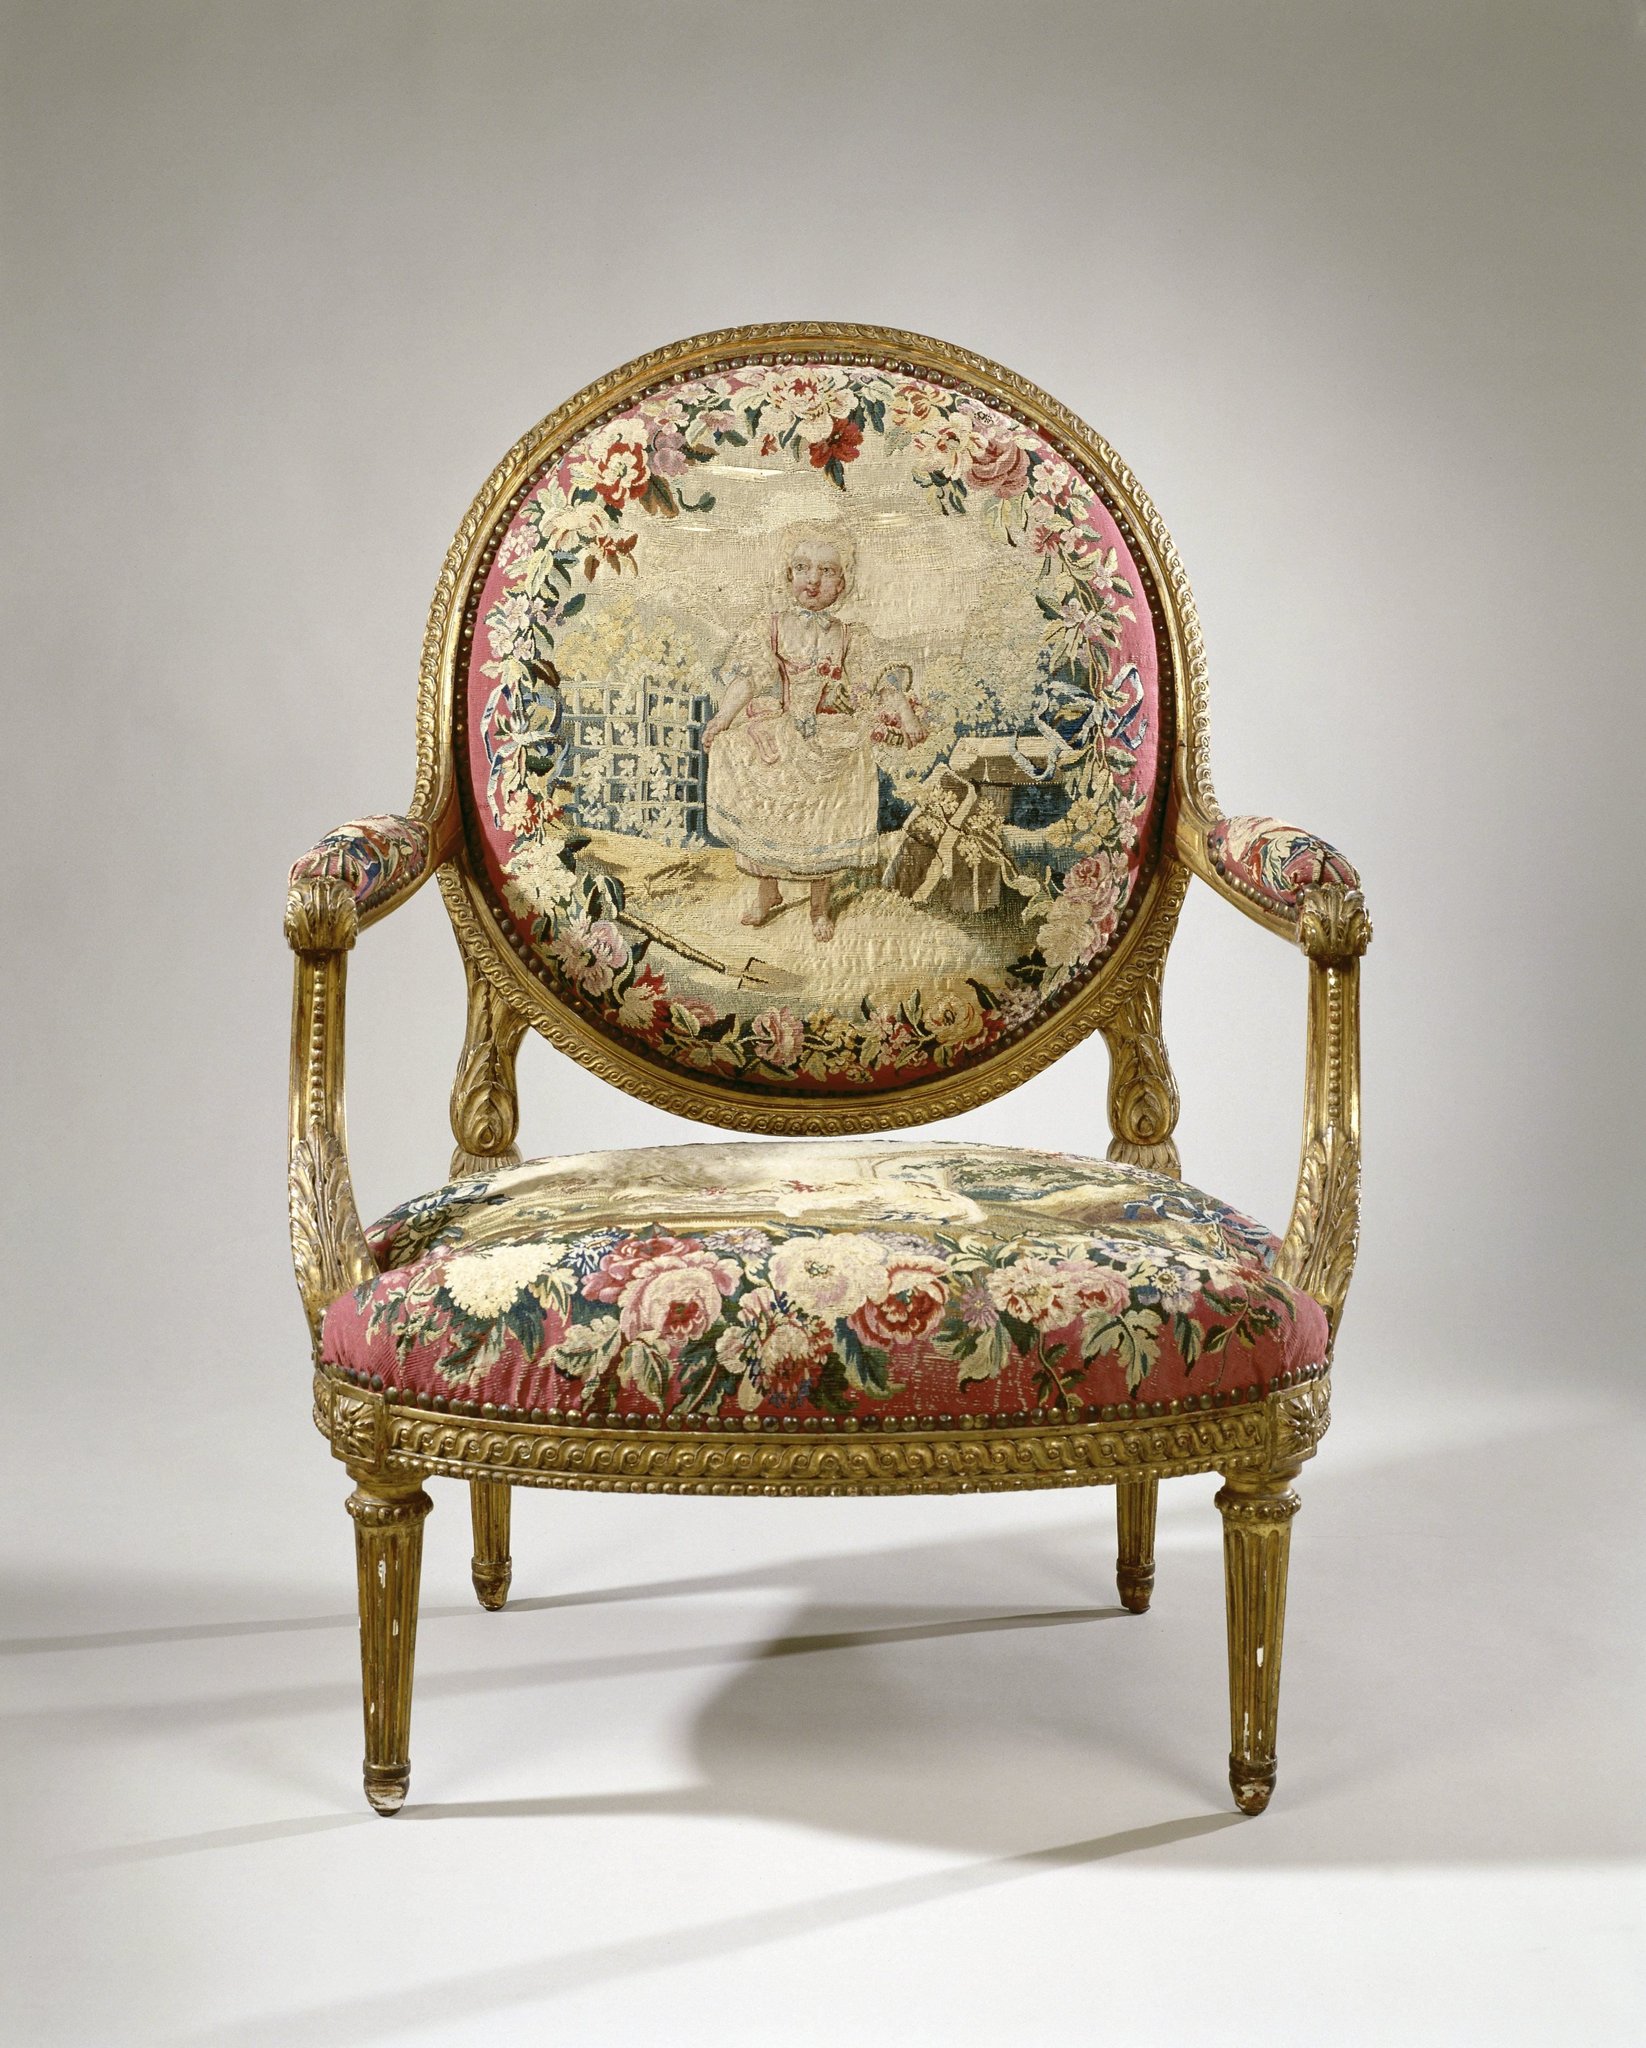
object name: chair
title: Armstoel bekleed met tapisserie met een meisje met een mand bloemen (petite jardinière/petite fille portant des fleurs) (rug) en de fabel van de twee hanen (zitting)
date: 1755-1765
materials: silk, wood, wool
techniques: gilding, tapestry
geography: paris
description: Armstoel van verguld beukenhout, rustend op conische gevormde poten. De armstoel maakt deel uit van een ameublement. Op het beklede gebogen zitraam en het beklede ovale rugraam zijn op een roze fond voorstellingen binnen bloemenkransen aangebracht (tapisserie de Beauvais). Zie tevens: BK-16657-a/e.